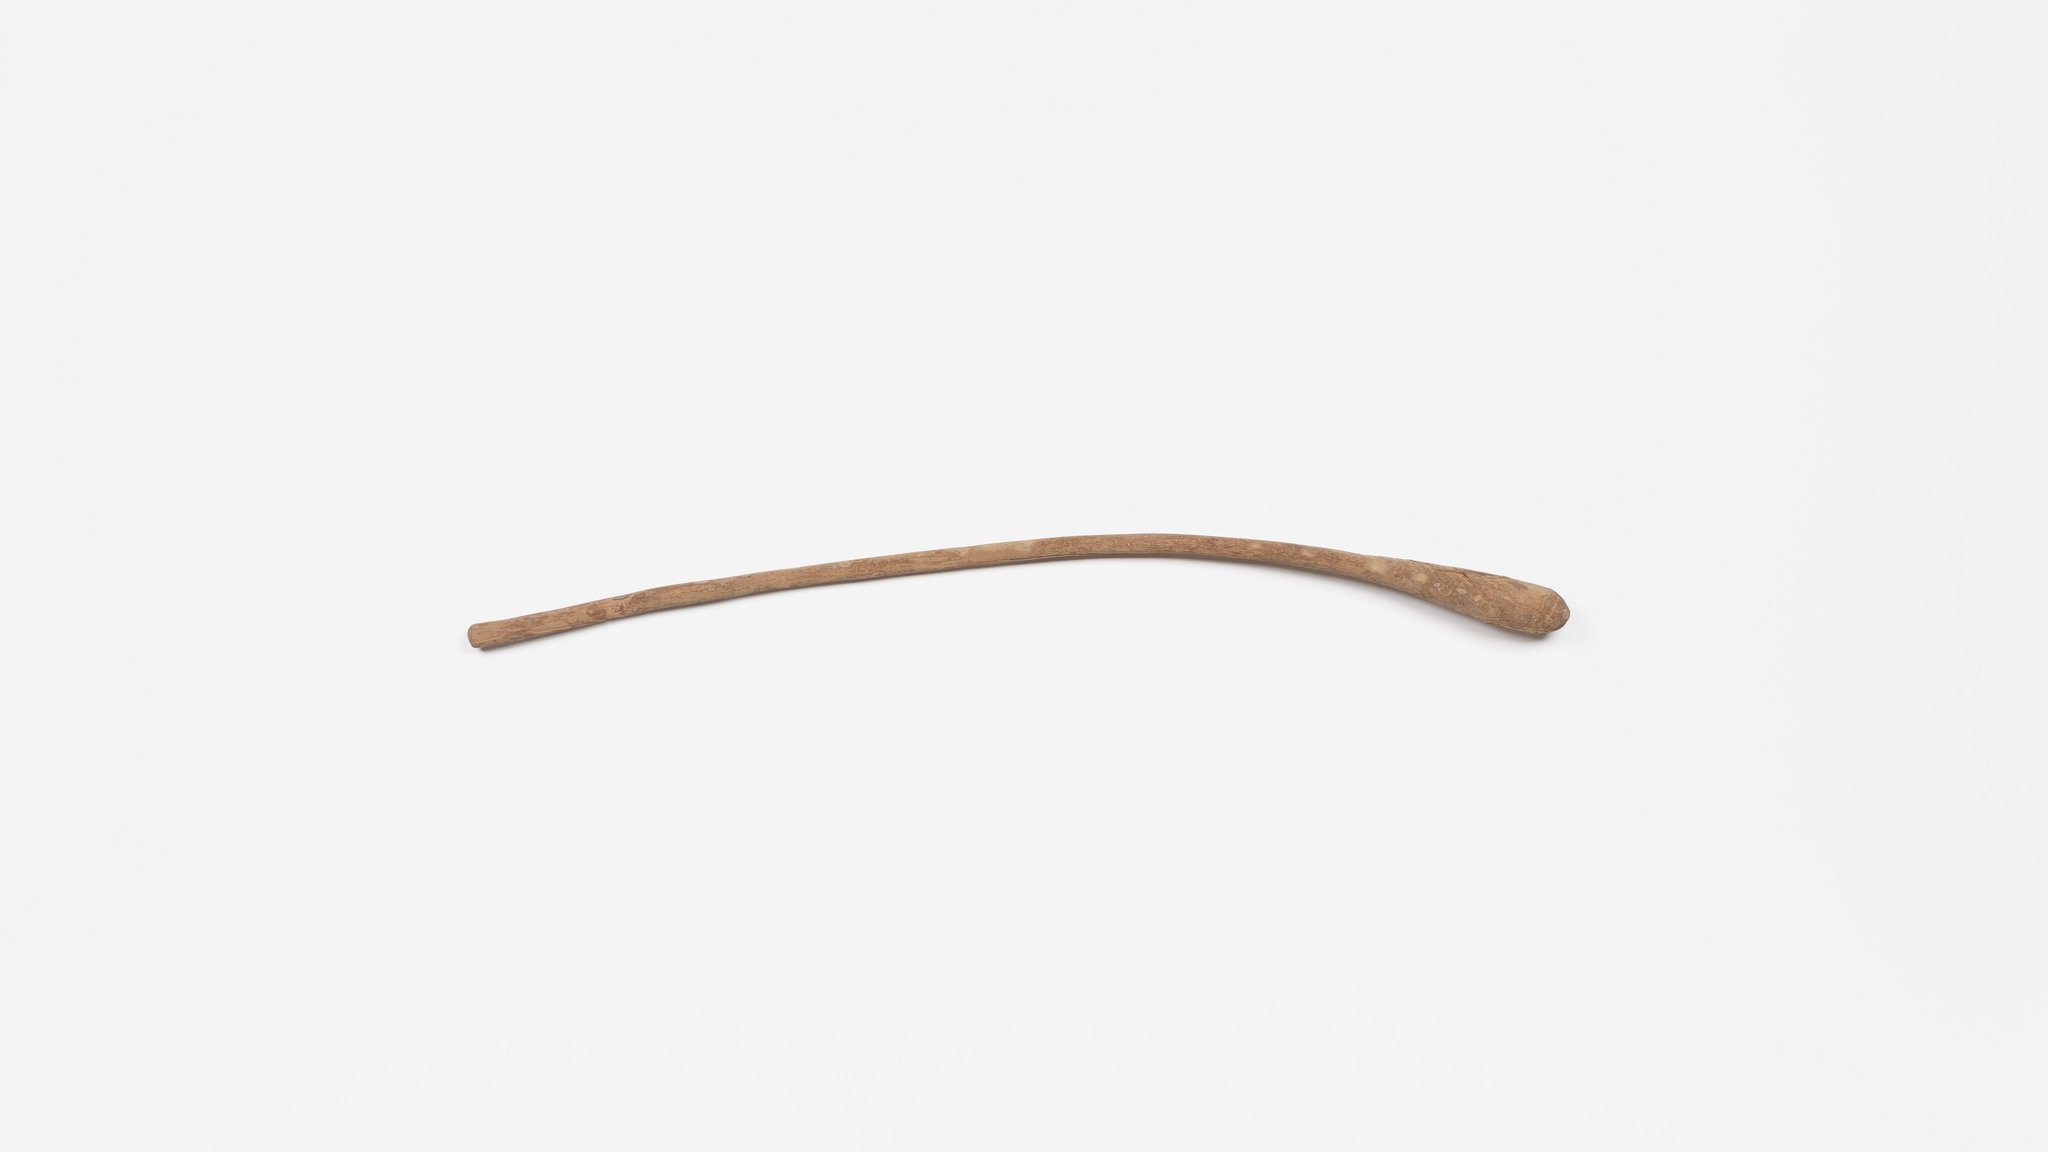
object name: club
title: Model Club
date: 1981-1802 BCE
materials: wood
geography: egypt